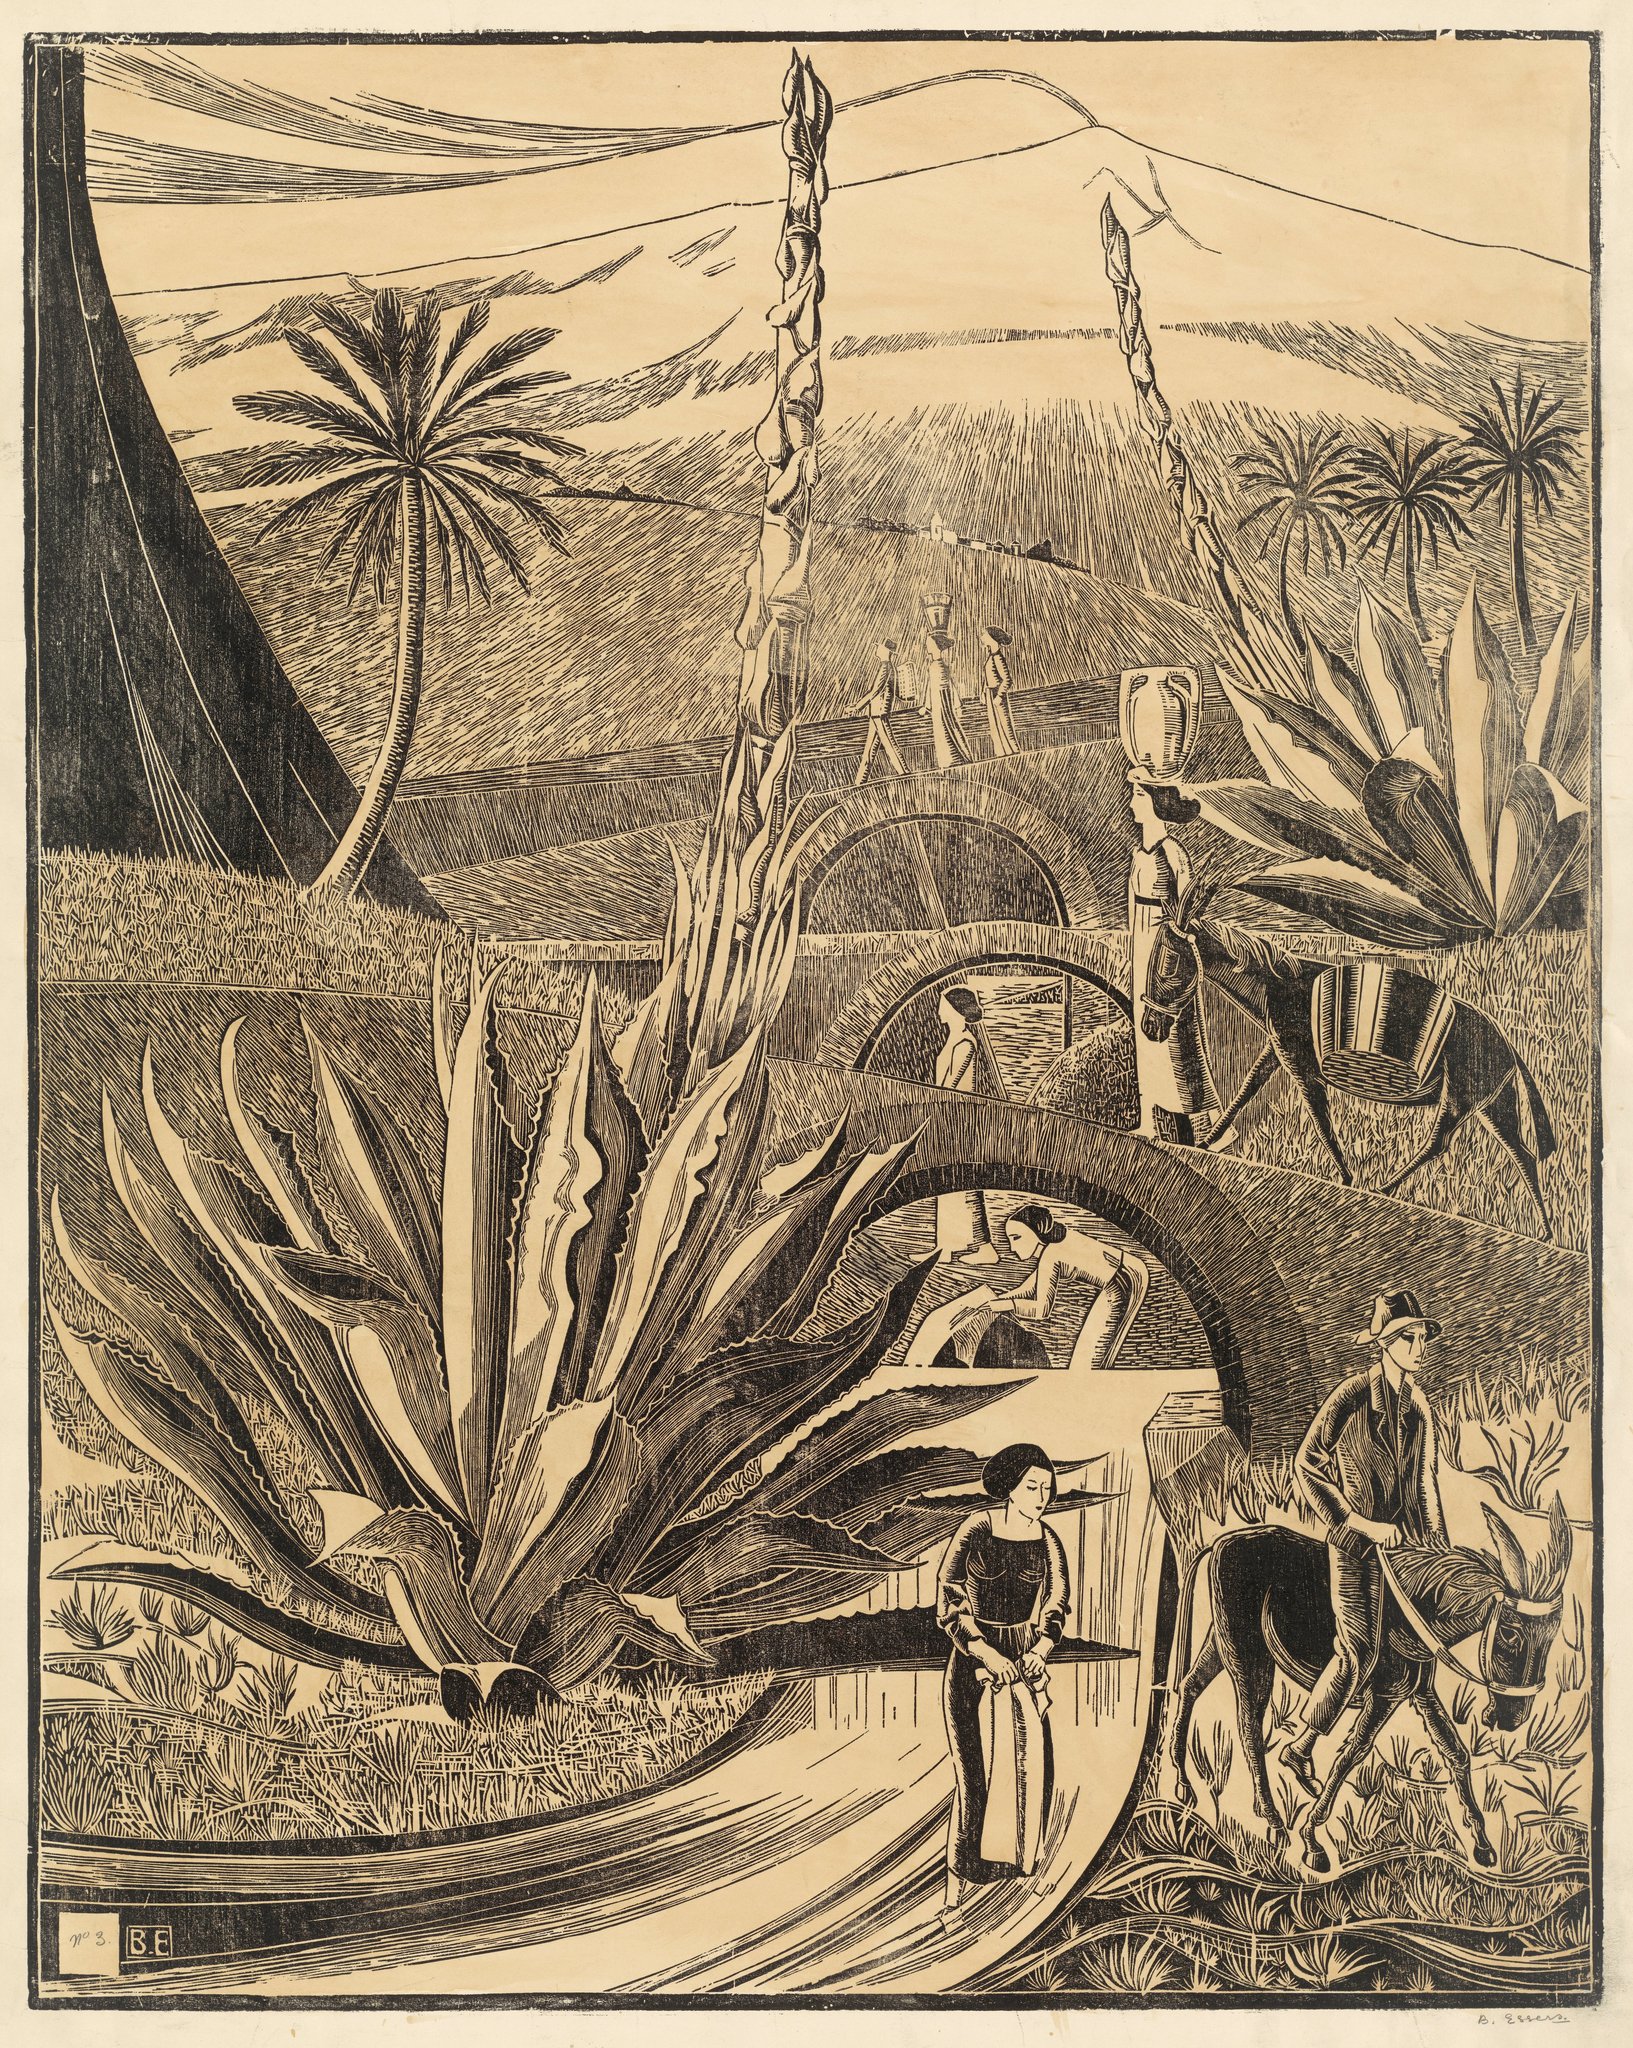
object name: print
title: Alocés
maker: bernard essers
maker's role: print maker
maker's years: 1893-1945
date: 1903-1931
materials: paper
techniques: woodcut